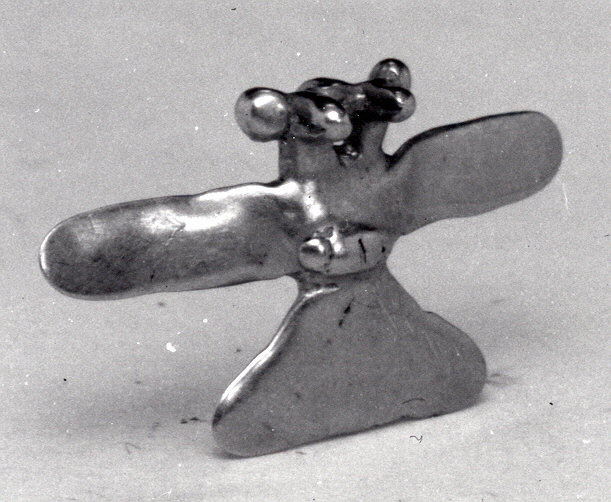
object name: pendant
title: Cast Gold Double-Eagle Pendant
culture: costa rican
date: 601-1600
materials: gold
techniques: casting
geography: costa rica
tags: eagles